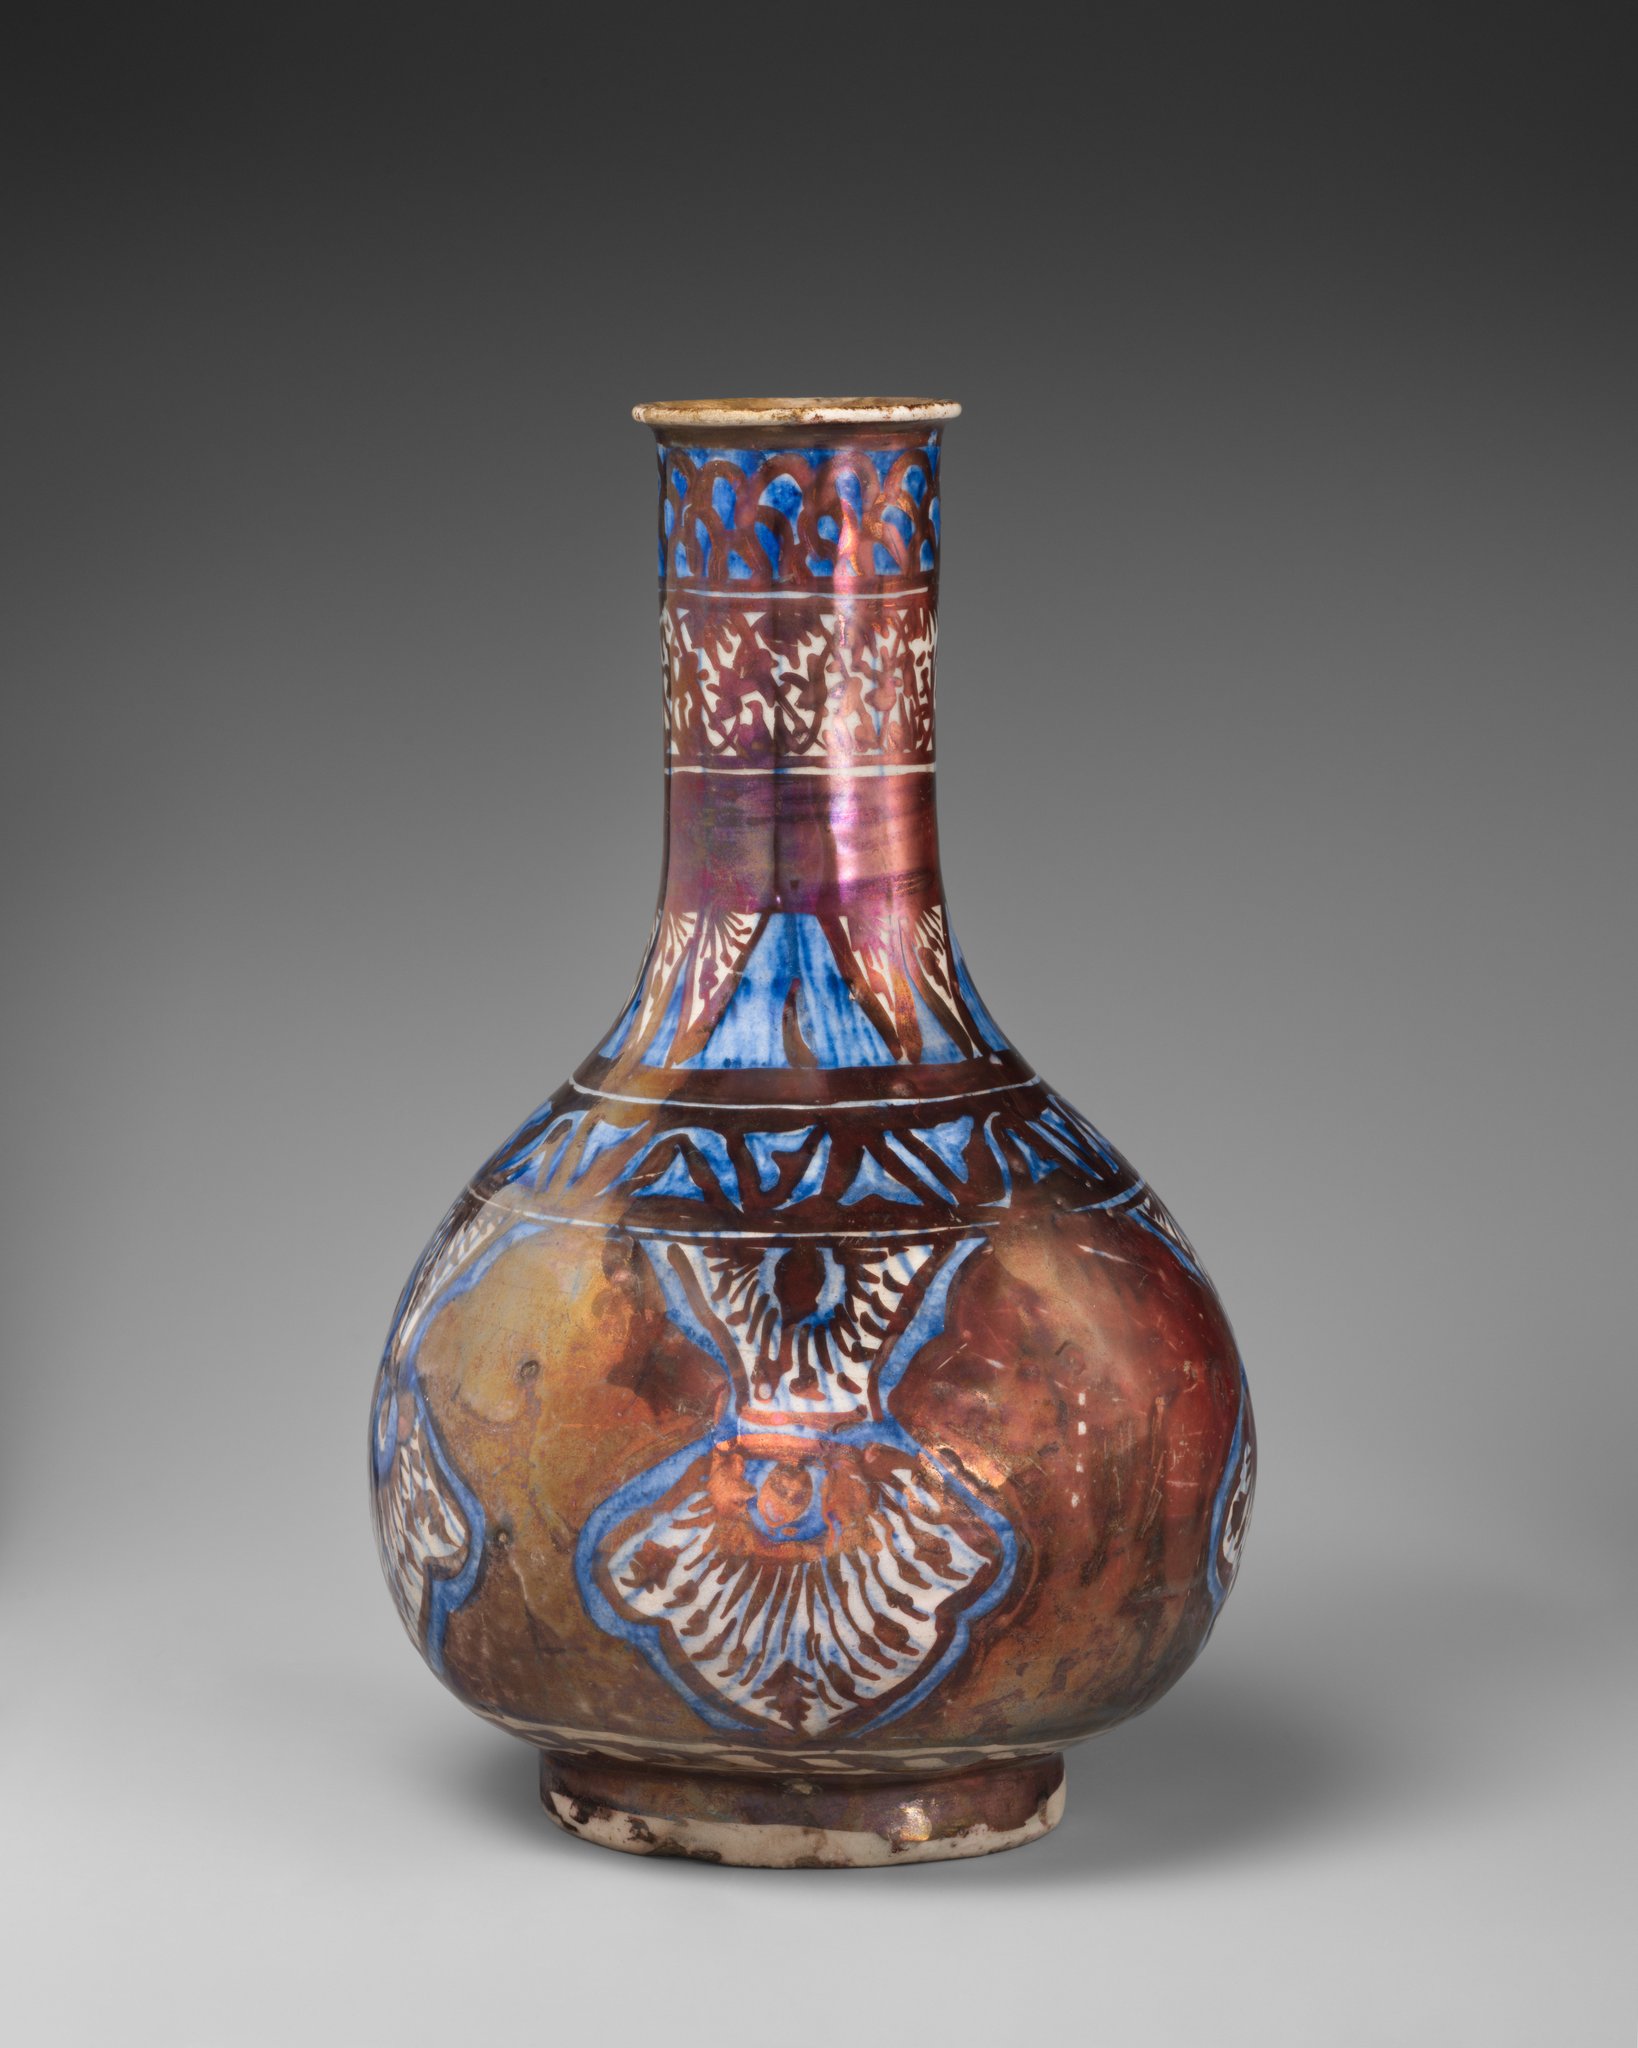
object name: bottle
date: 1601-1700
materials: glaze, stonepaste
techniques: luster painting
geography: iran